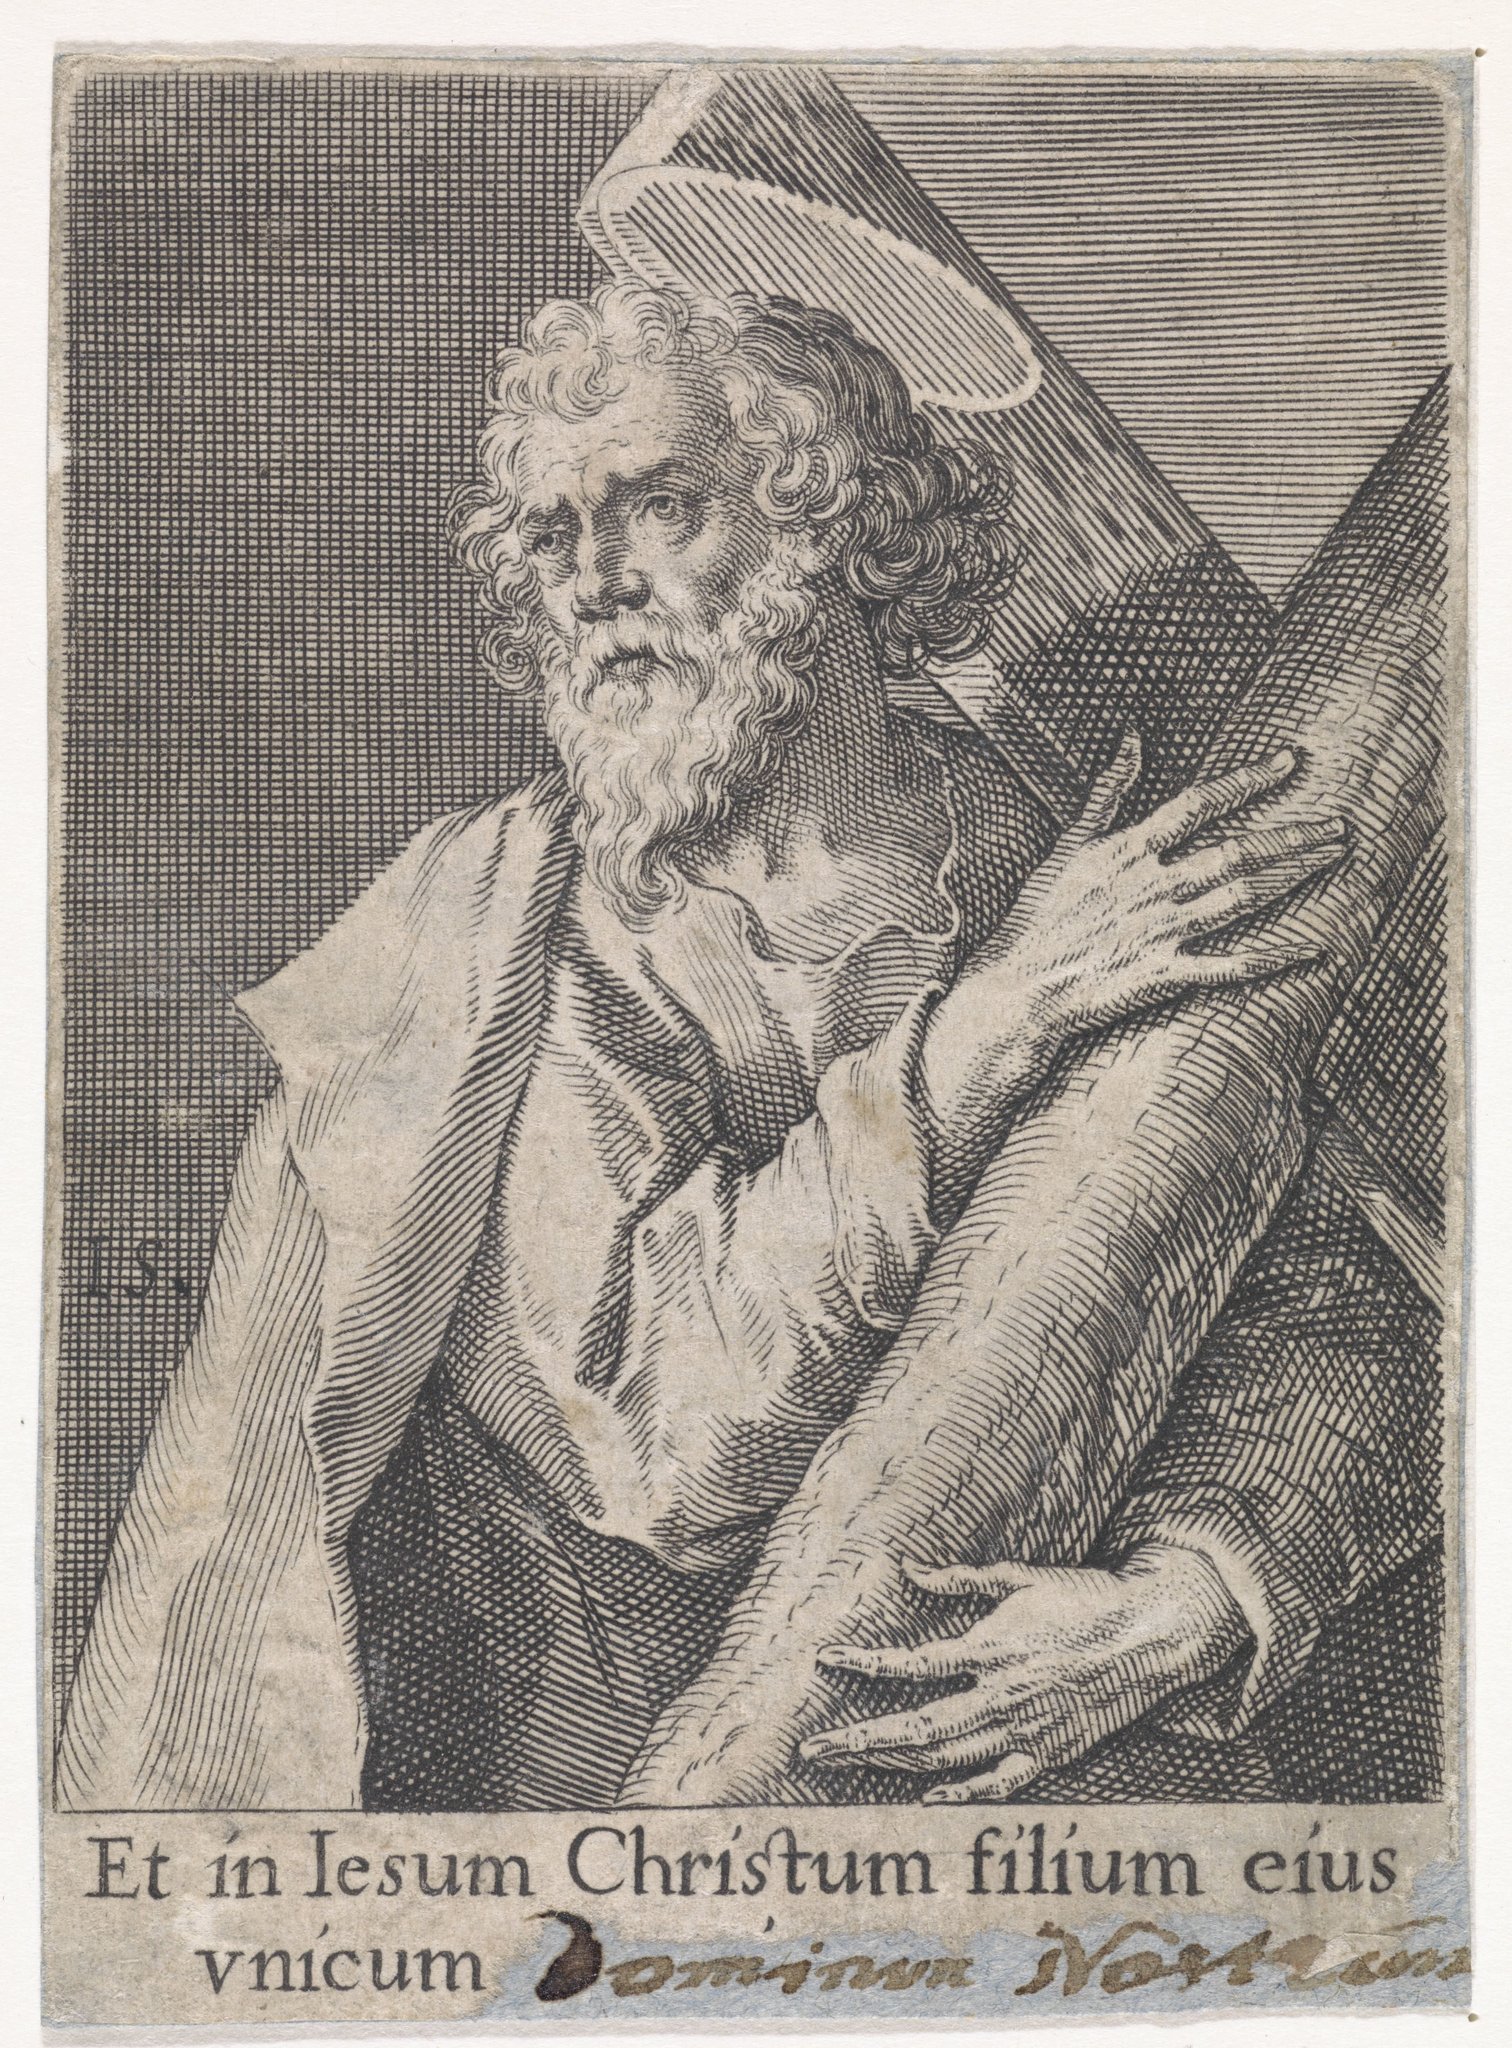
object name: print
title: Christus, Maria en de twaalf apostelen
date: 1570-1600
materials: paper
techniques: engraving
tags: the apostle andrew; possible attributes: book, x-shaped cross, fish, fishing-net, rope, scroll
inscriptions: collector's mark: Lugt 240, caption: ‘Dominum Nostrum’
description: De apostel Andreas, met als attribuut het x-vormig kruis. De prent heeft een Latijns onderschrijft met een regel uit het Credo. De vierde prent in een serie van veertien waarvan de prenten met een apostel genummerd zijn van 1 tot 12.